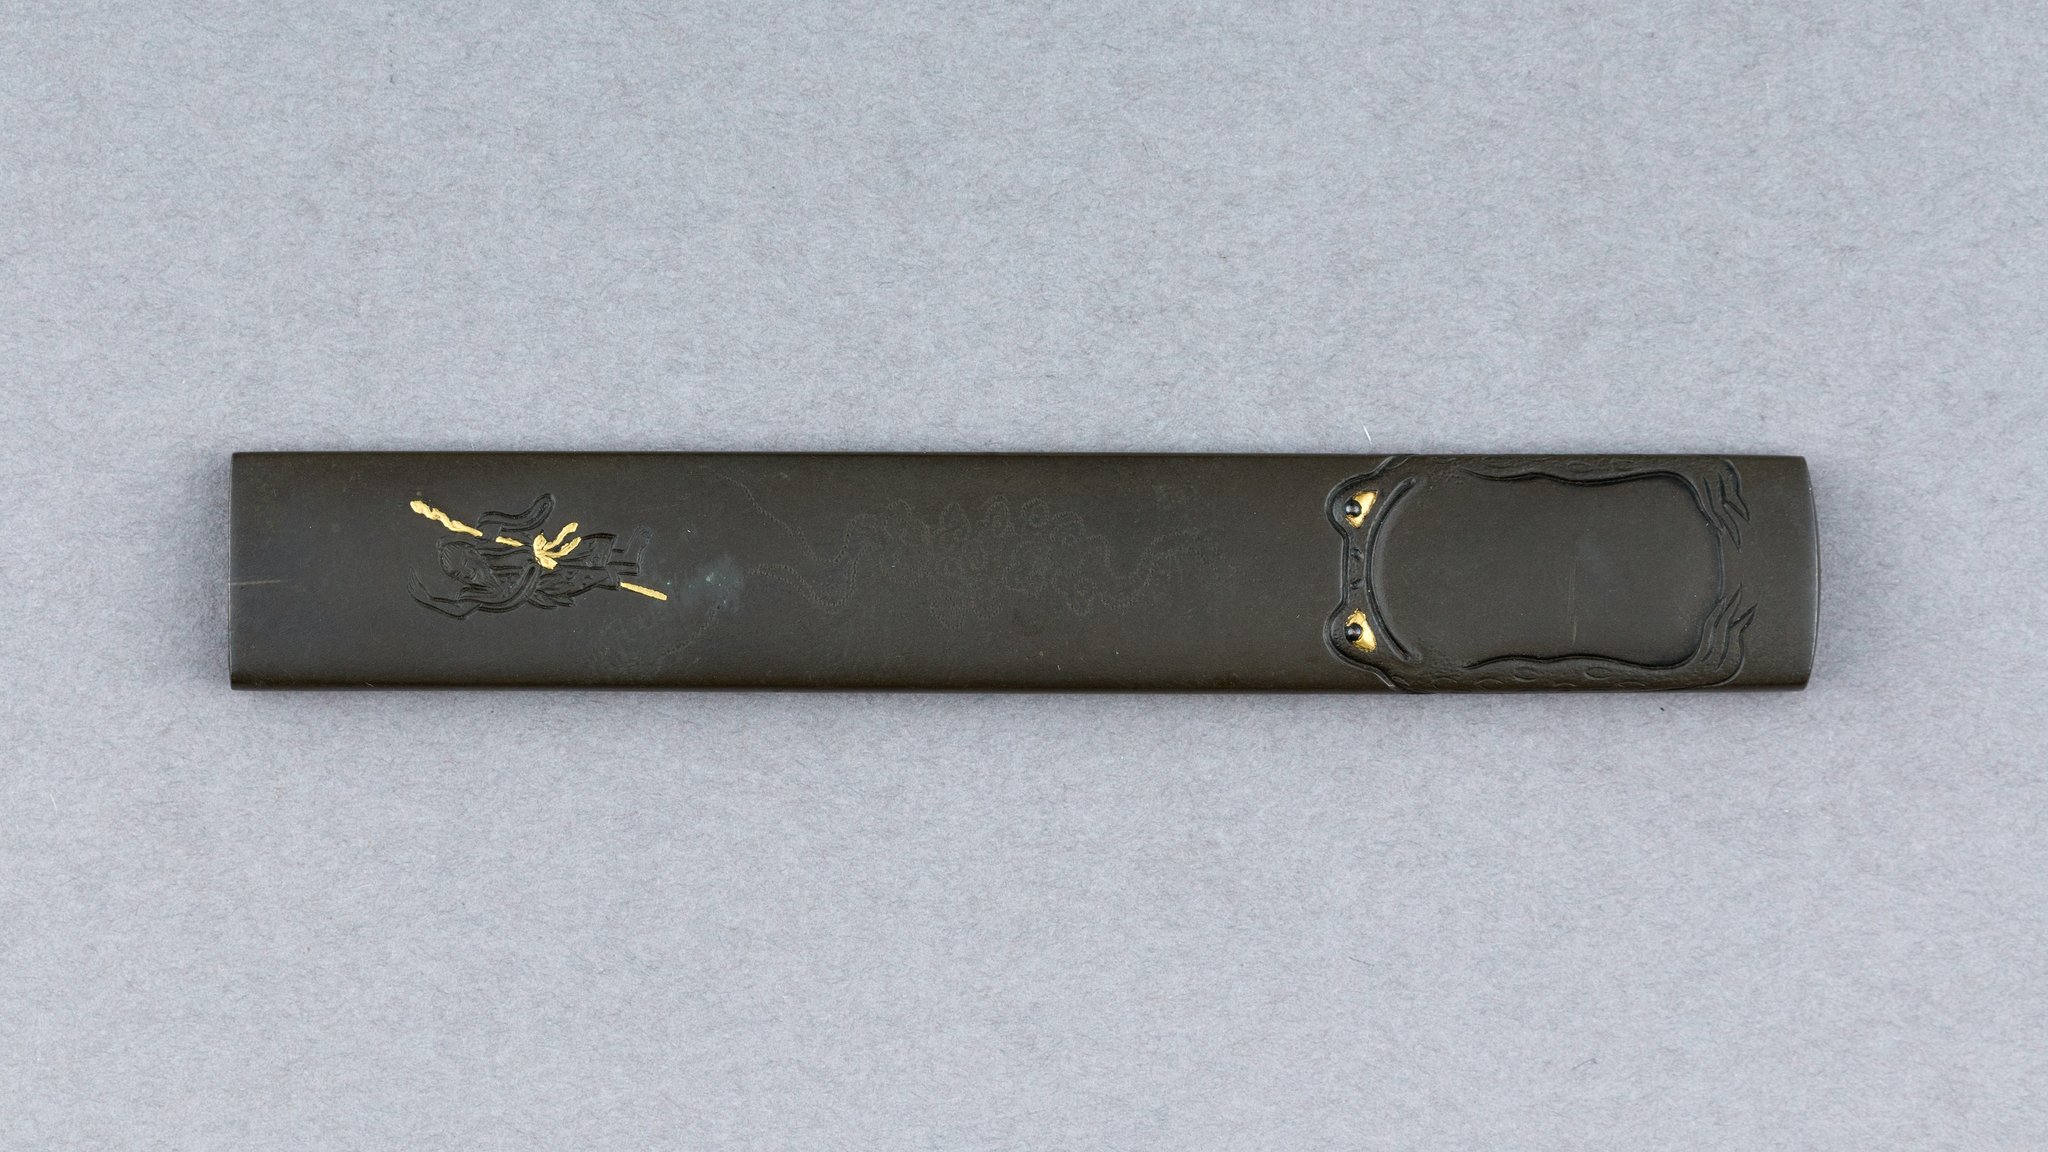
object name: knife handle kozuka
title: Knife Handle (Kozuka)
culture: japanese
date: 1615-1868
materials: silver alloy, gold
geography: japan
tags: men,frogs